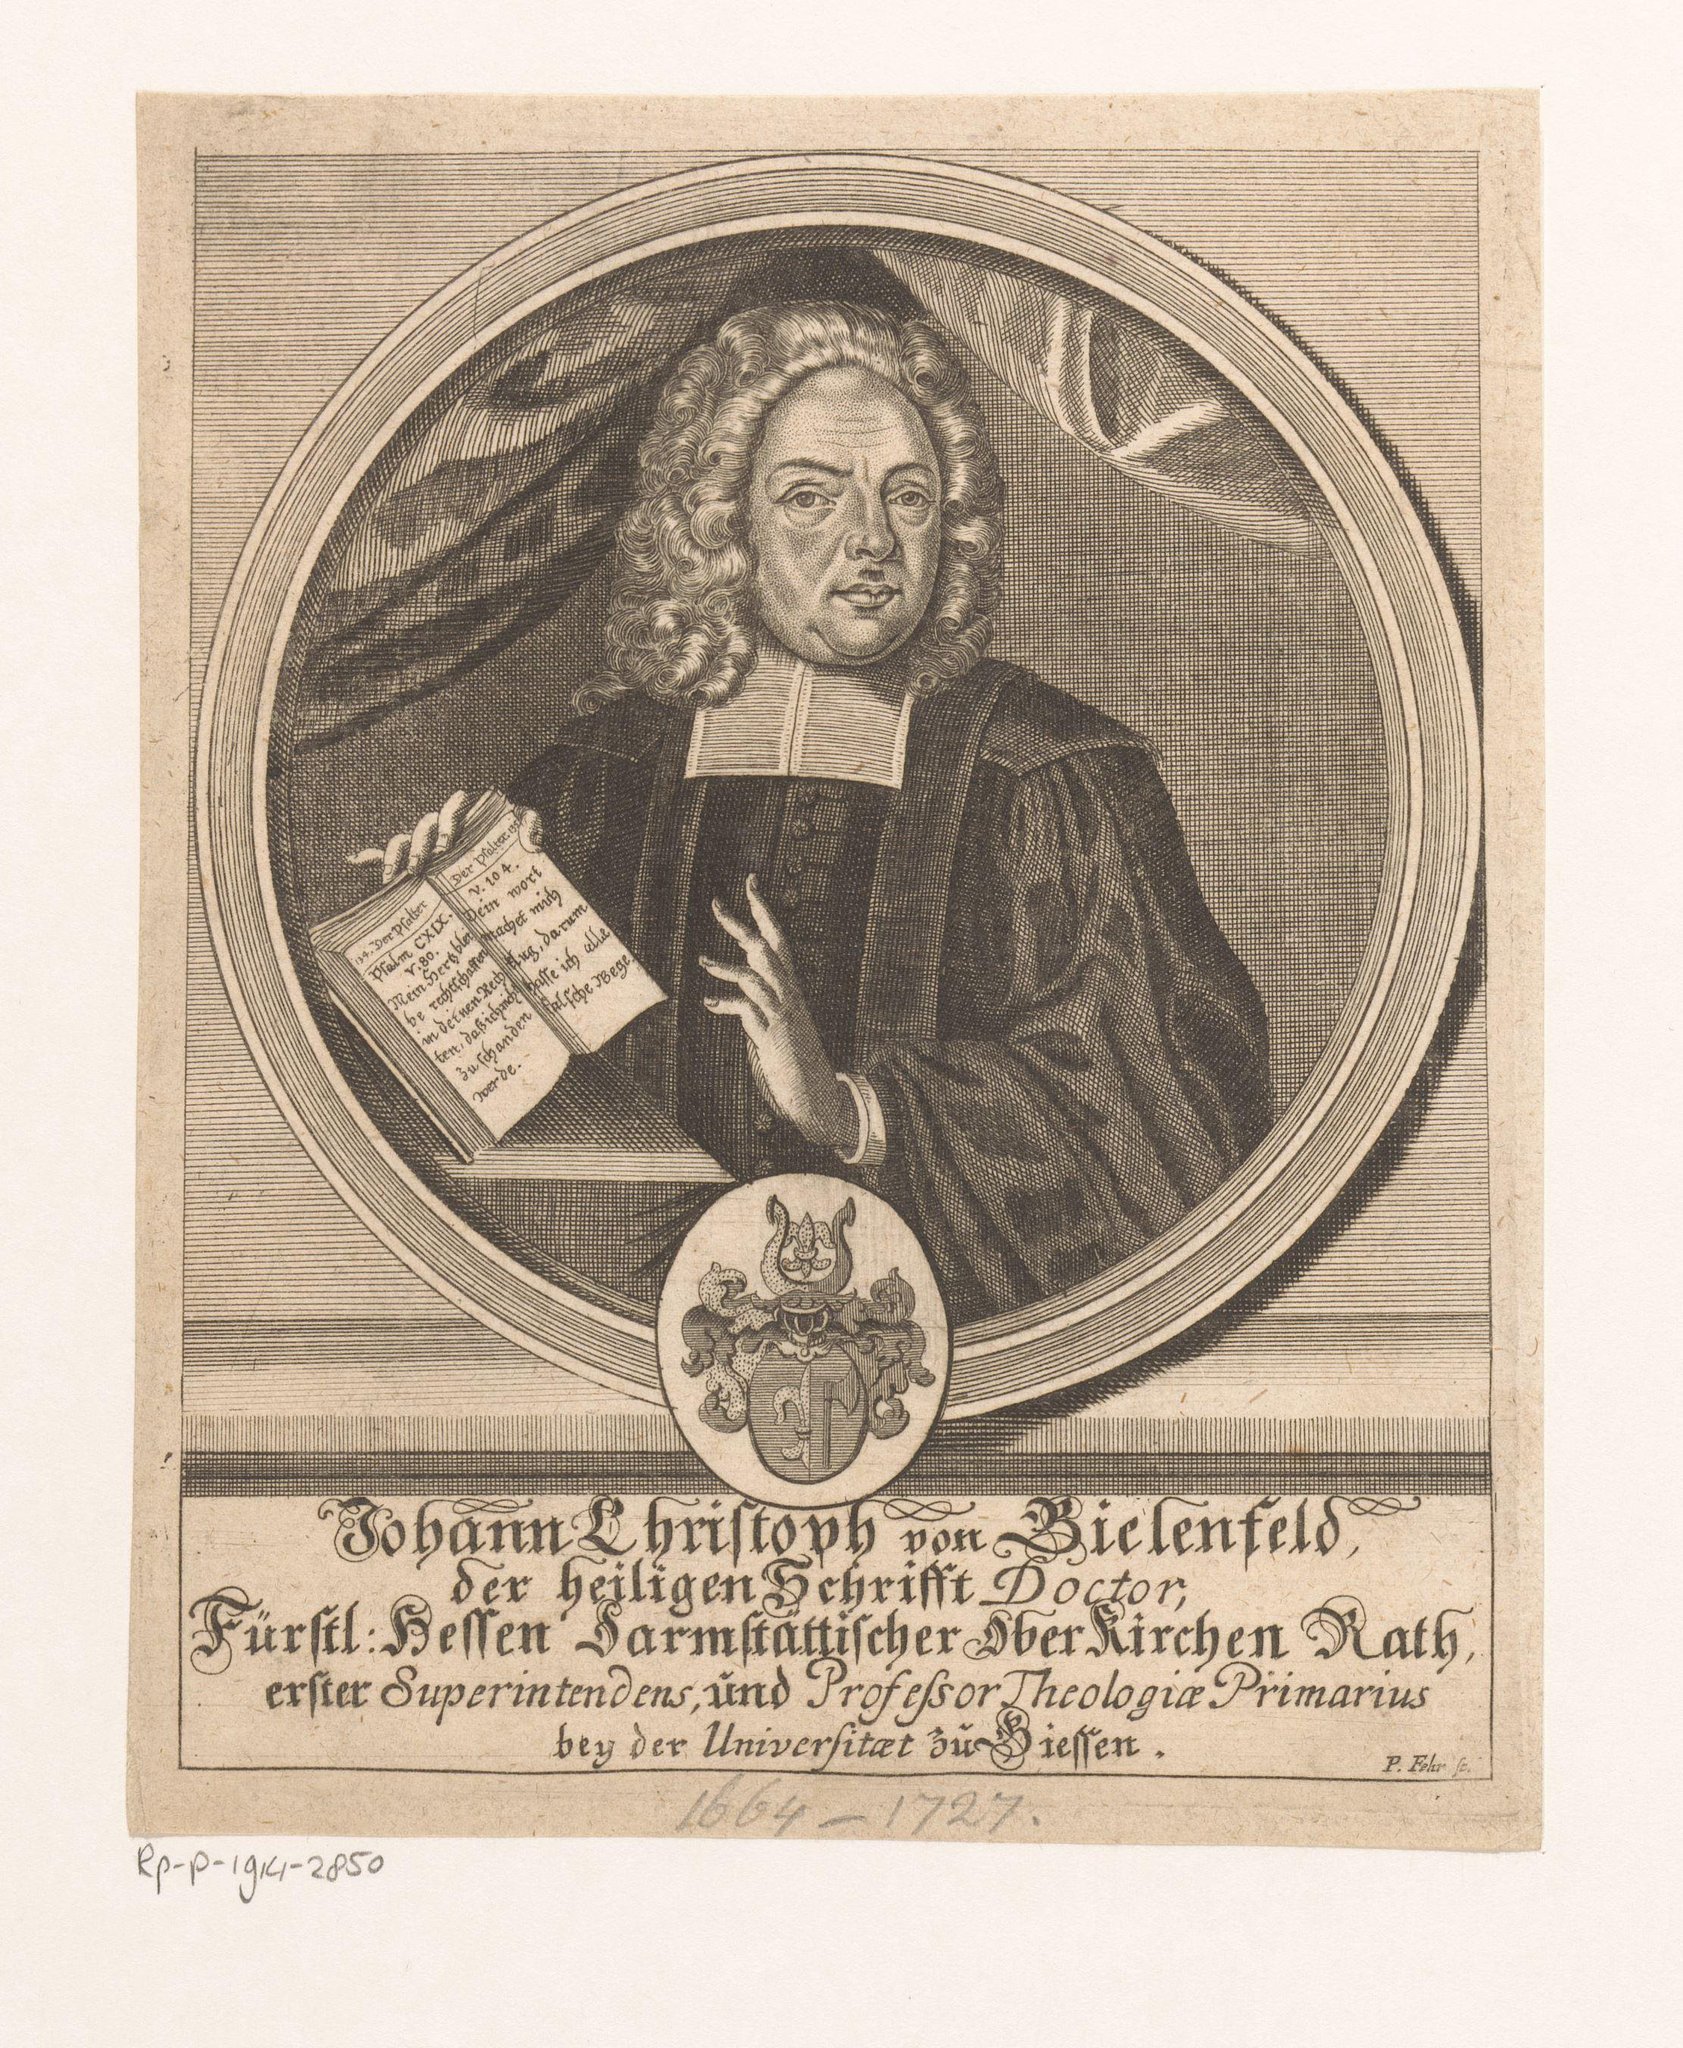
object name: print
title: Portret van Christoph von Bilefeld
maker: peter fehr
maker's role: print maker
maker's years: 1681-1740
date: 1691-1740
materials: paper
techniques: engraving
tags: historical persons, book, armorial bearing, heraldry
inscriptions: collector's mark: Lugt 2228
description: Het open boek in zijn rechterhand verwijst naar twee psalmen.